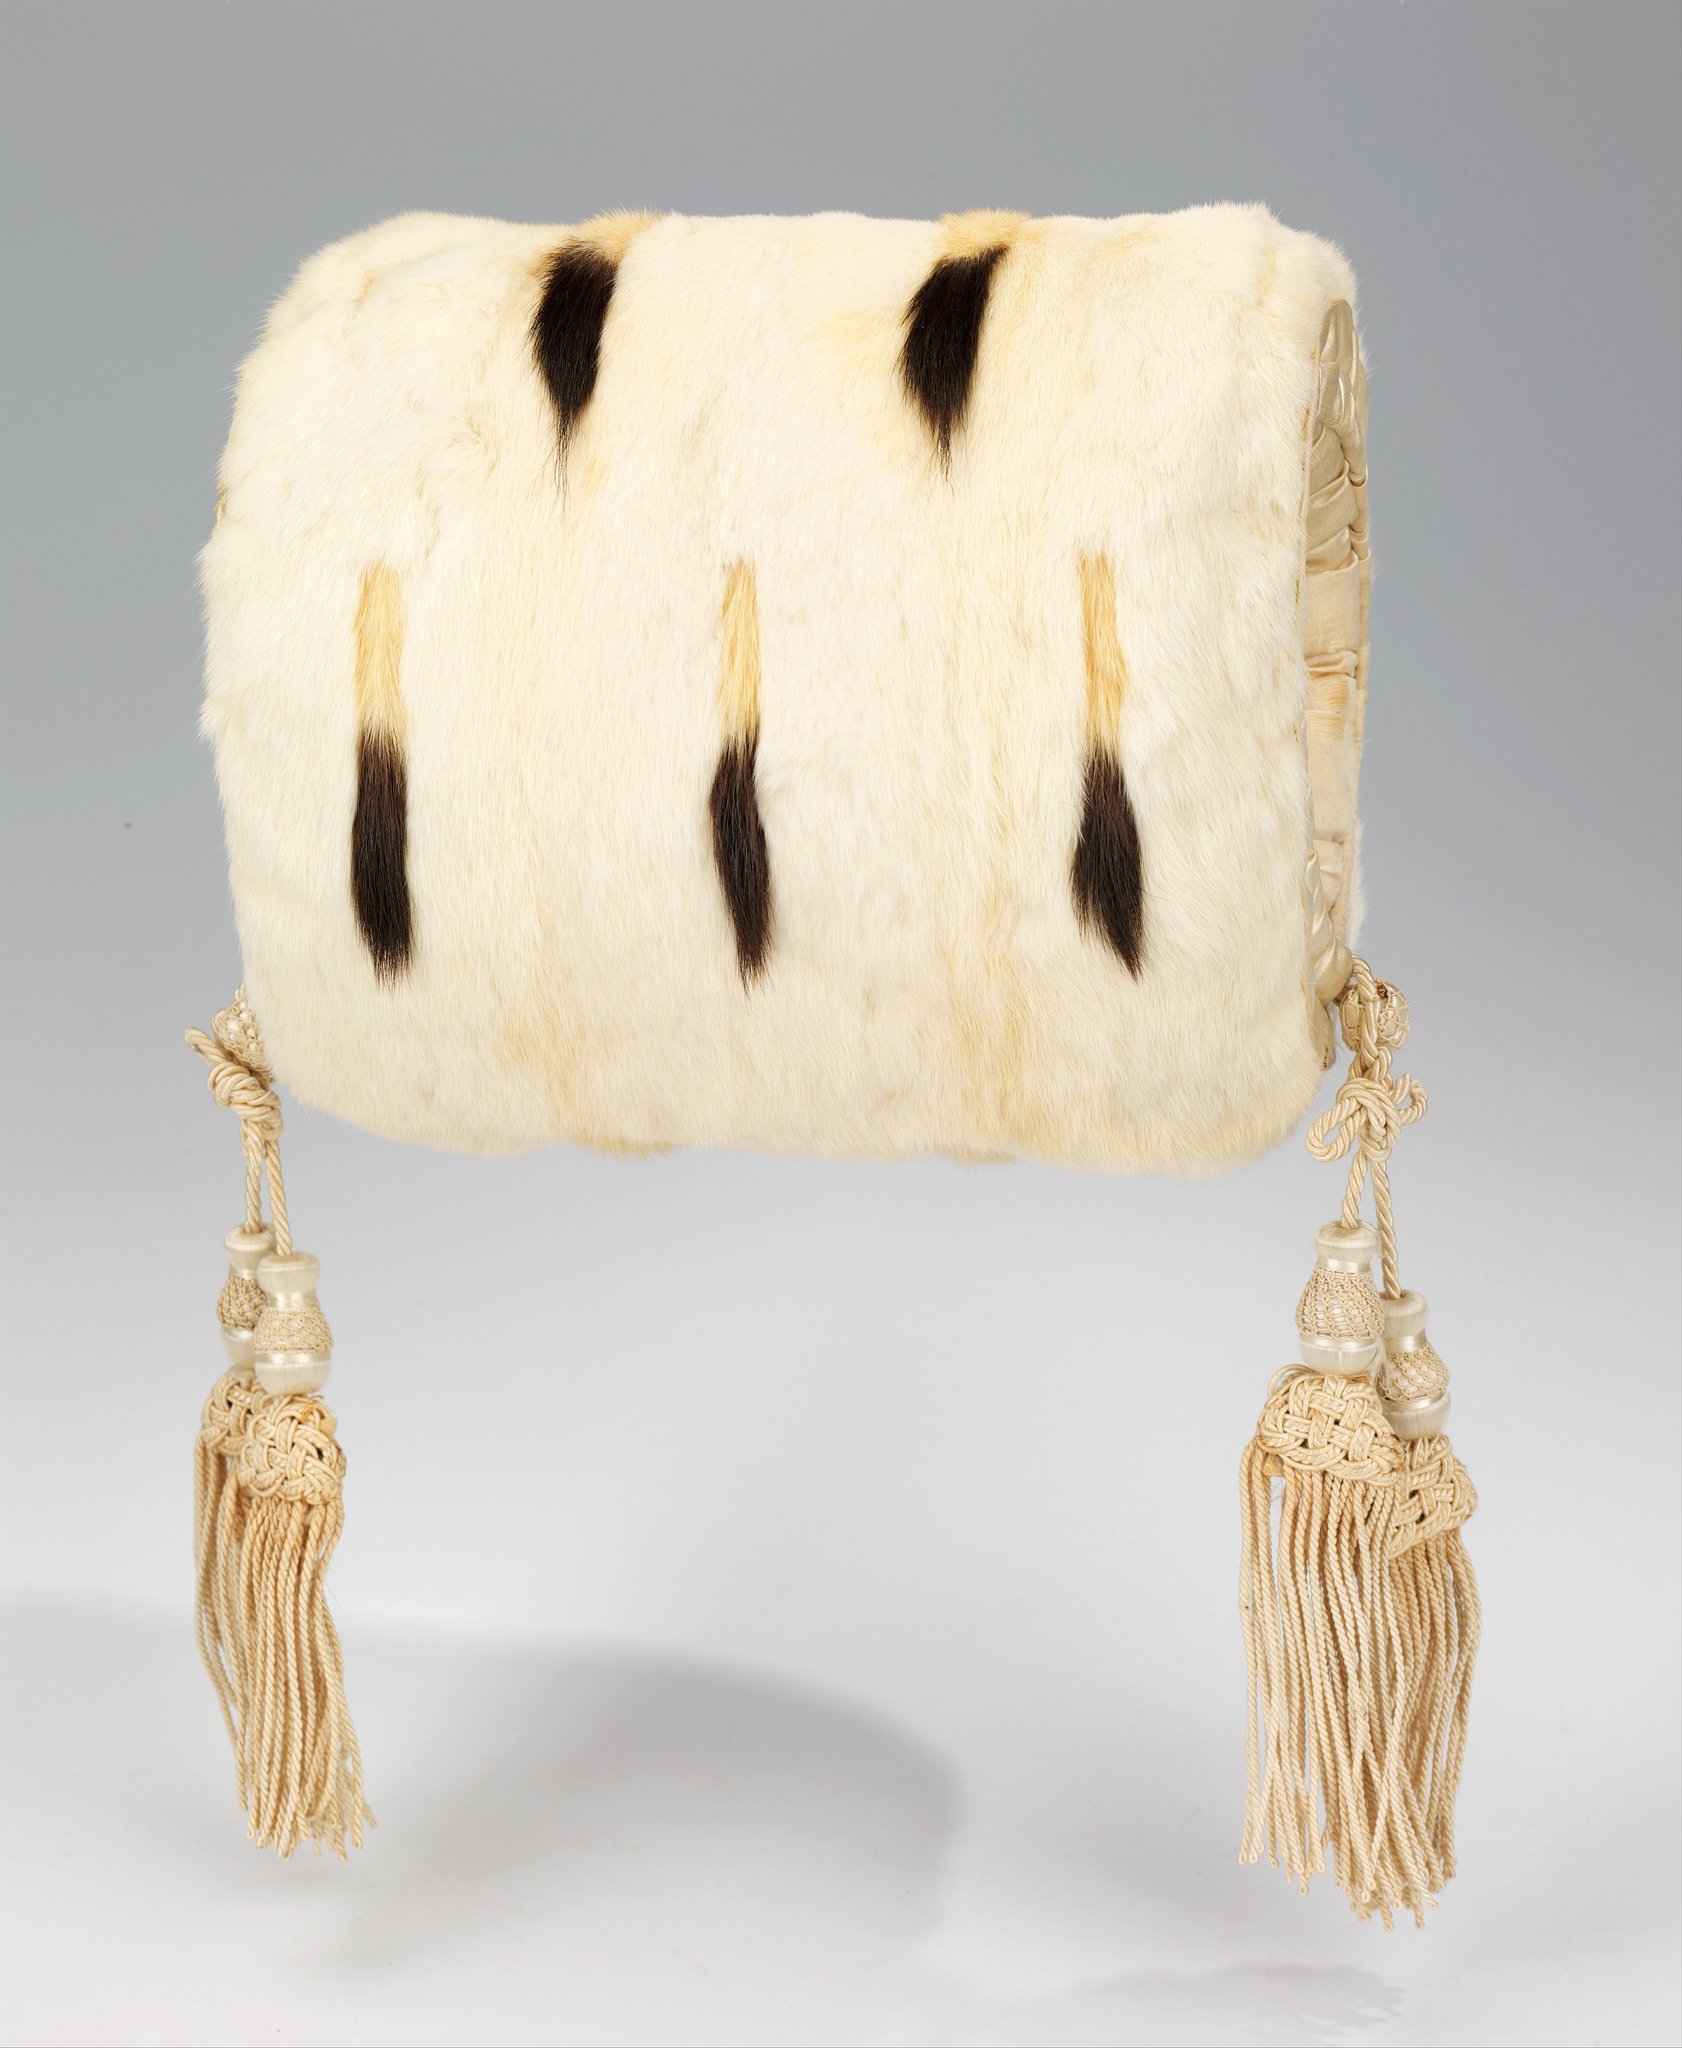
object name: evening muff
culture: american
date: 1876-1900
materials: fur, silk